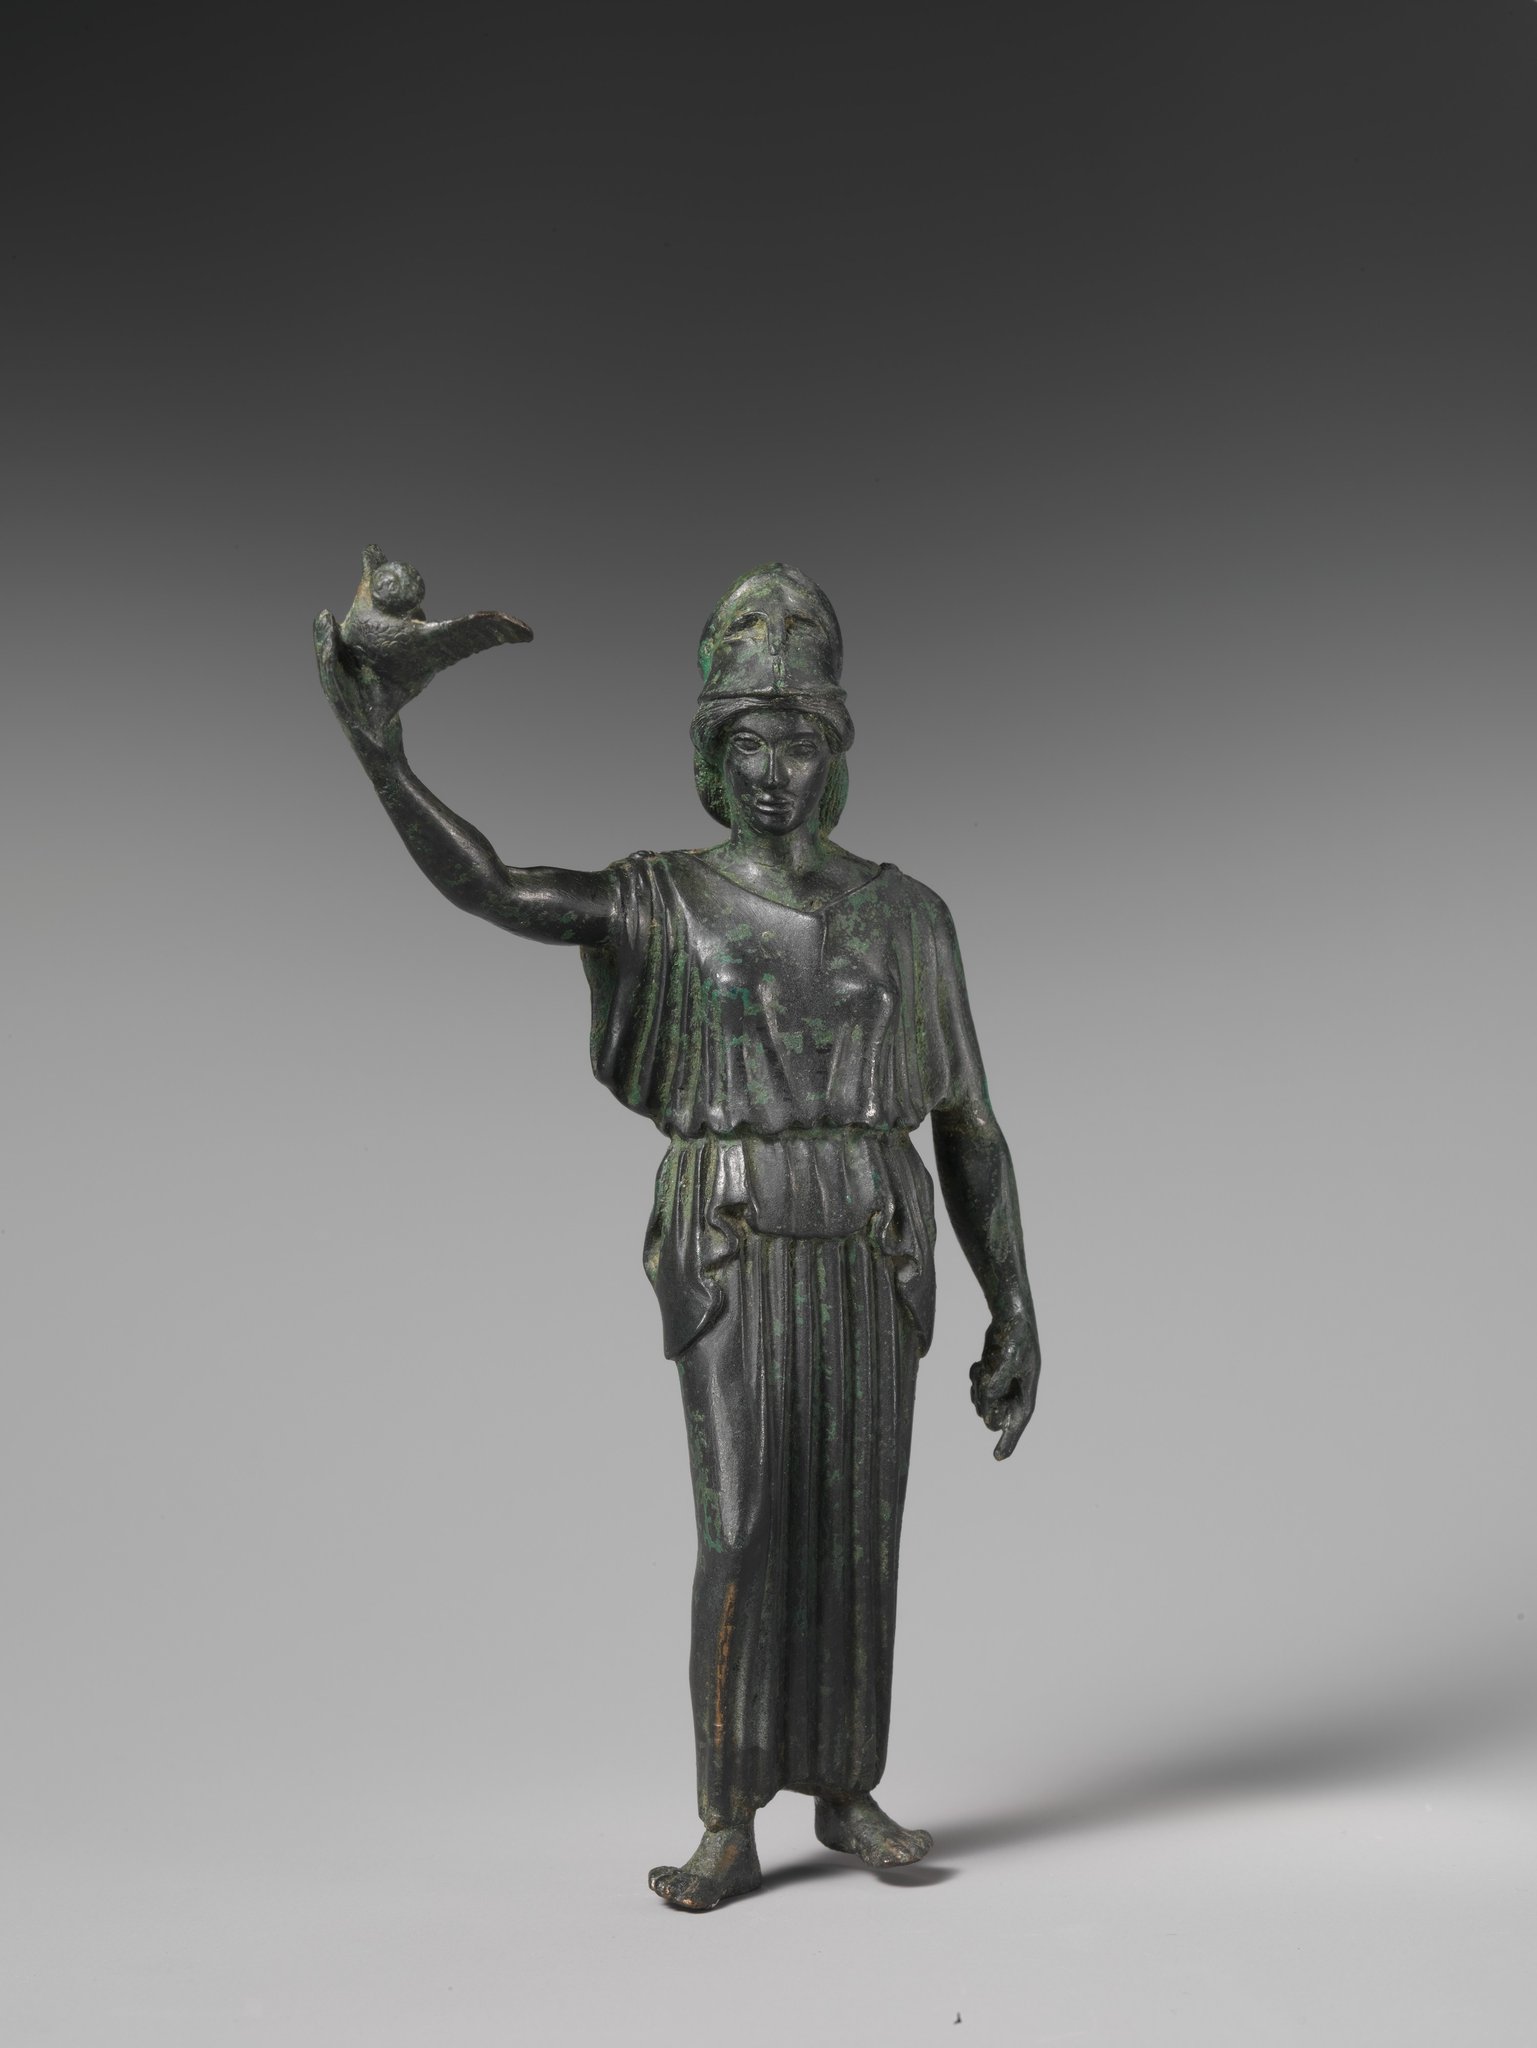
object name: statuette of athena flying her owl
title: Bronze statuette of Athena flying her owl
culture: greek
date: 460 BCE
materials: bronze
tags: athena,owls